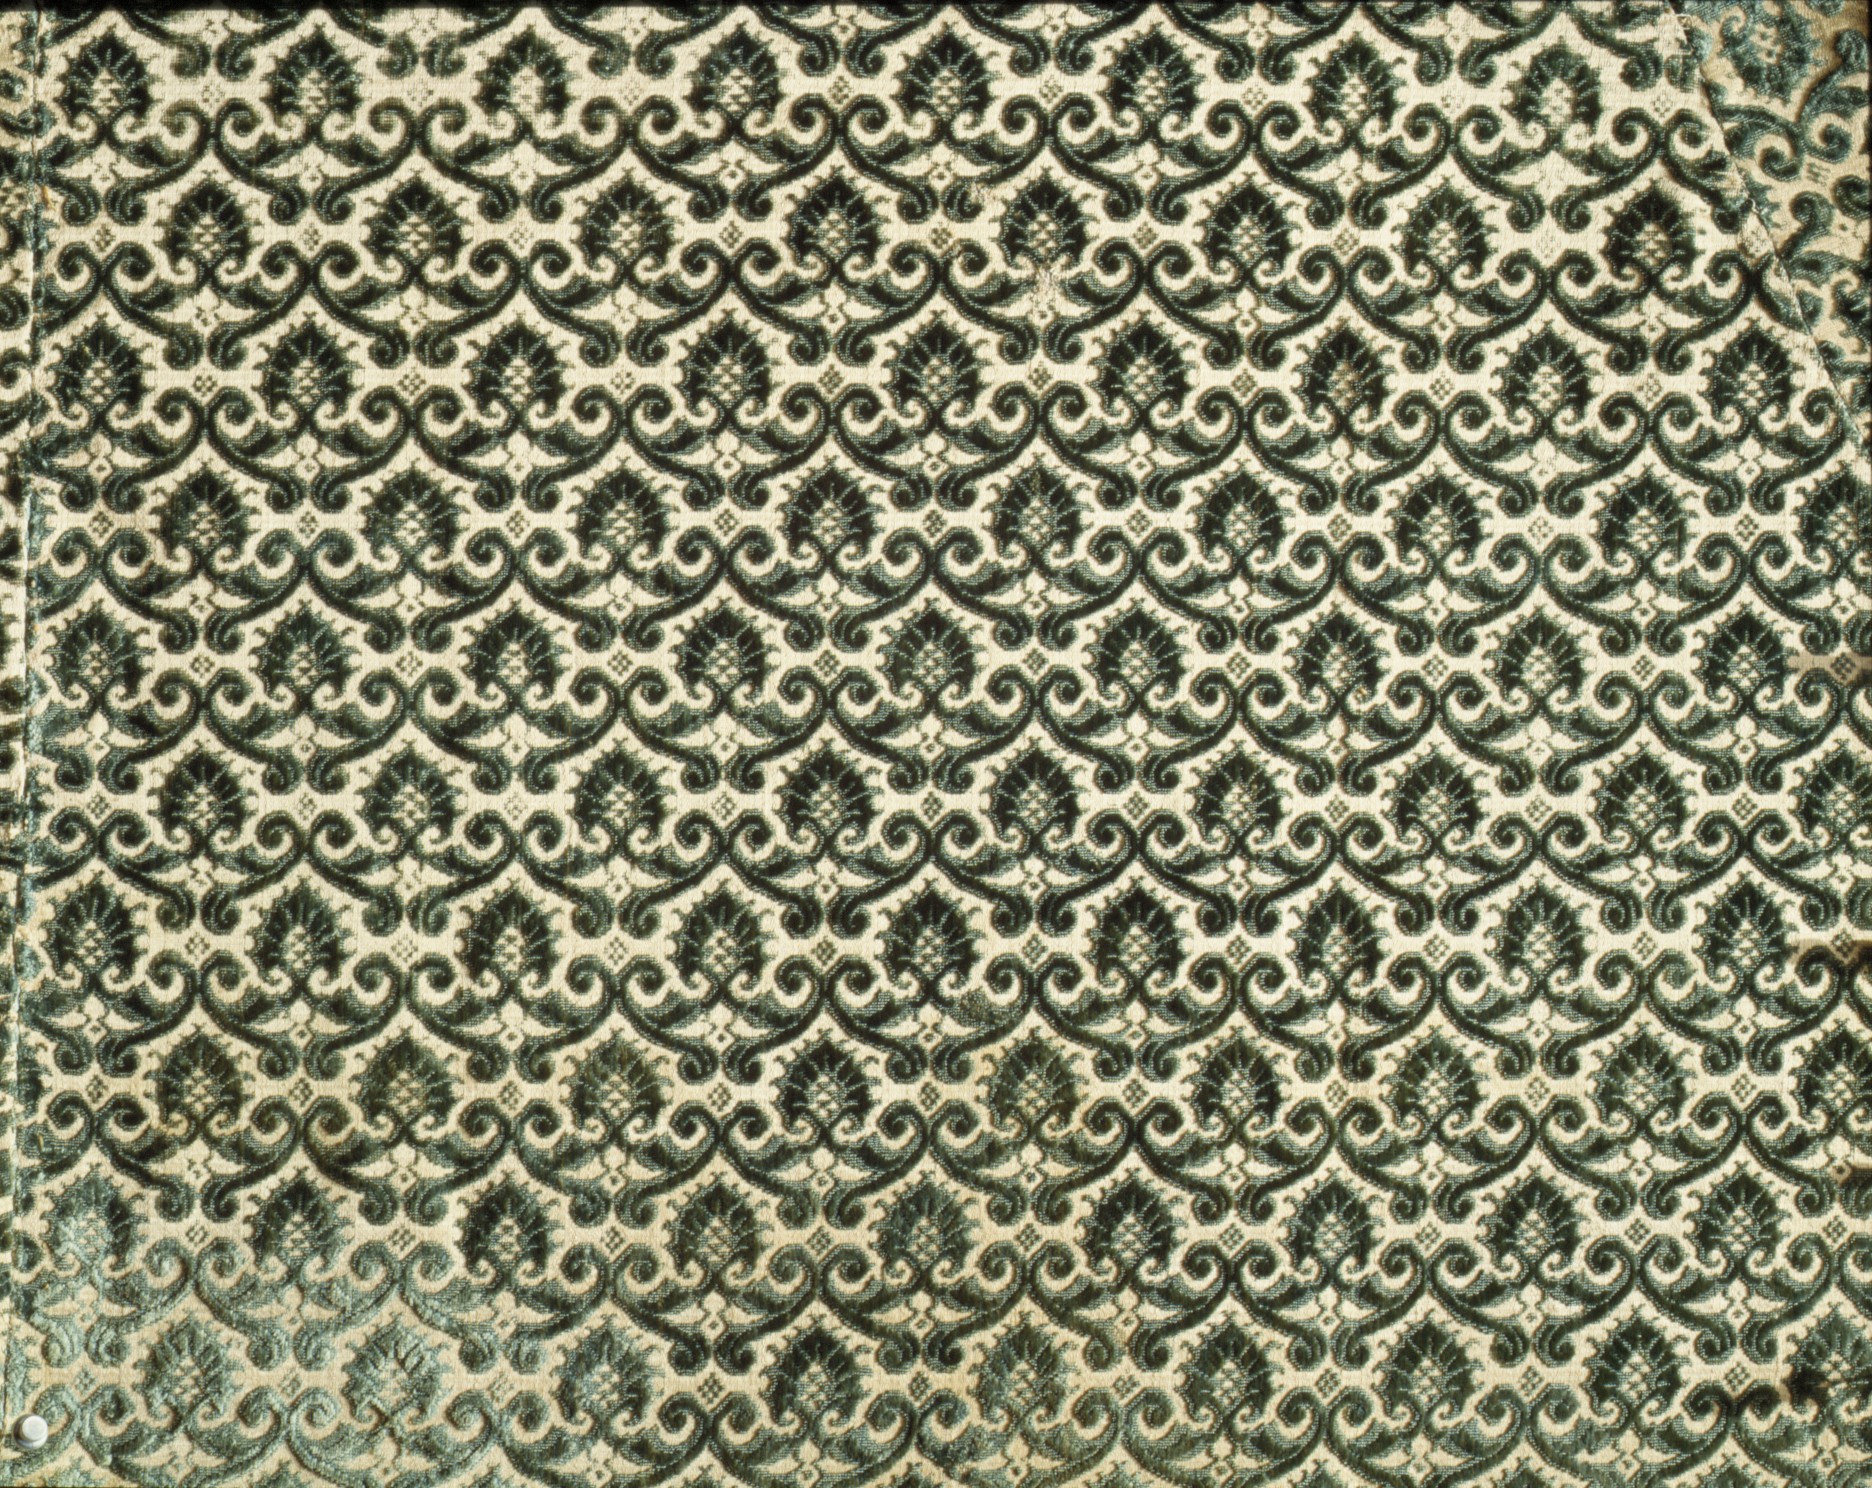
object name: panel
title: Panels of velvet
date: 1567-1633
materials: silk, velvet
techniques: cutting, voiding